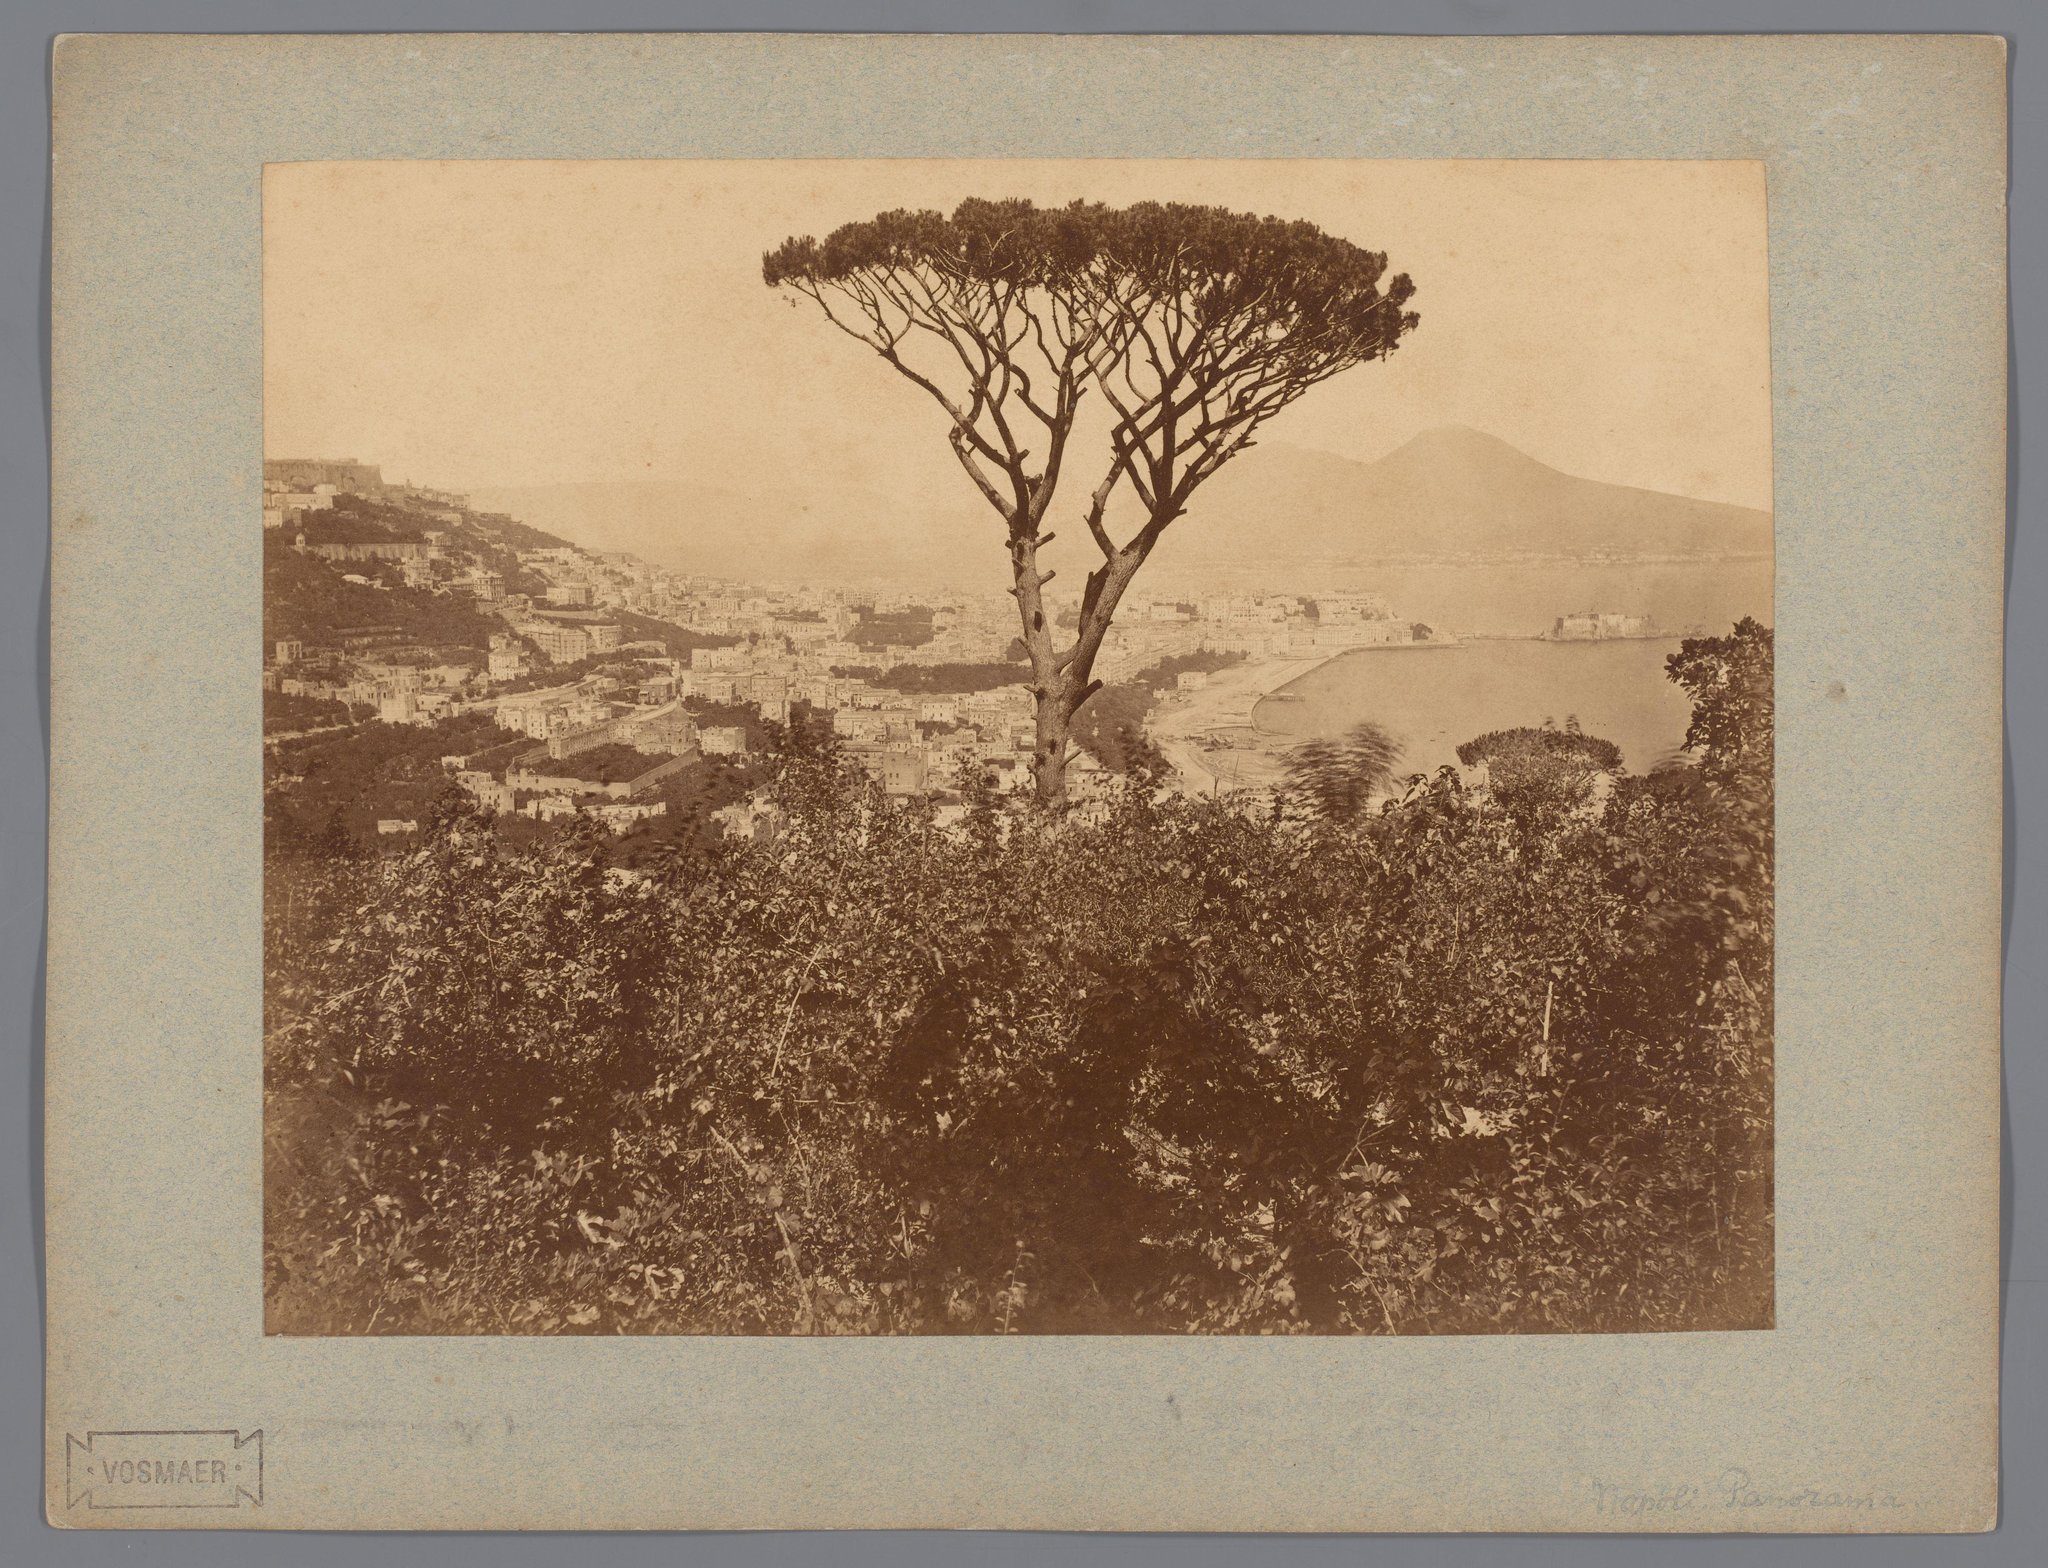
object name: photograph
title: Gezicht op Posilippo, bij Napels, met pijnboom op de voorgrond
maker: giorgio sommer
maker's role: fotograaf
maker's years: 1834-1914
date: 1860-1890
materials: cardboard, paper, photographic support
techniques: albumen print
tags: trees, coast, posillipo, collina di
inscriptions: stamp: ‘VOSMAER’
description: Gezicht op Posilippo, bij Napels, met pijnboom op de voorgrond.